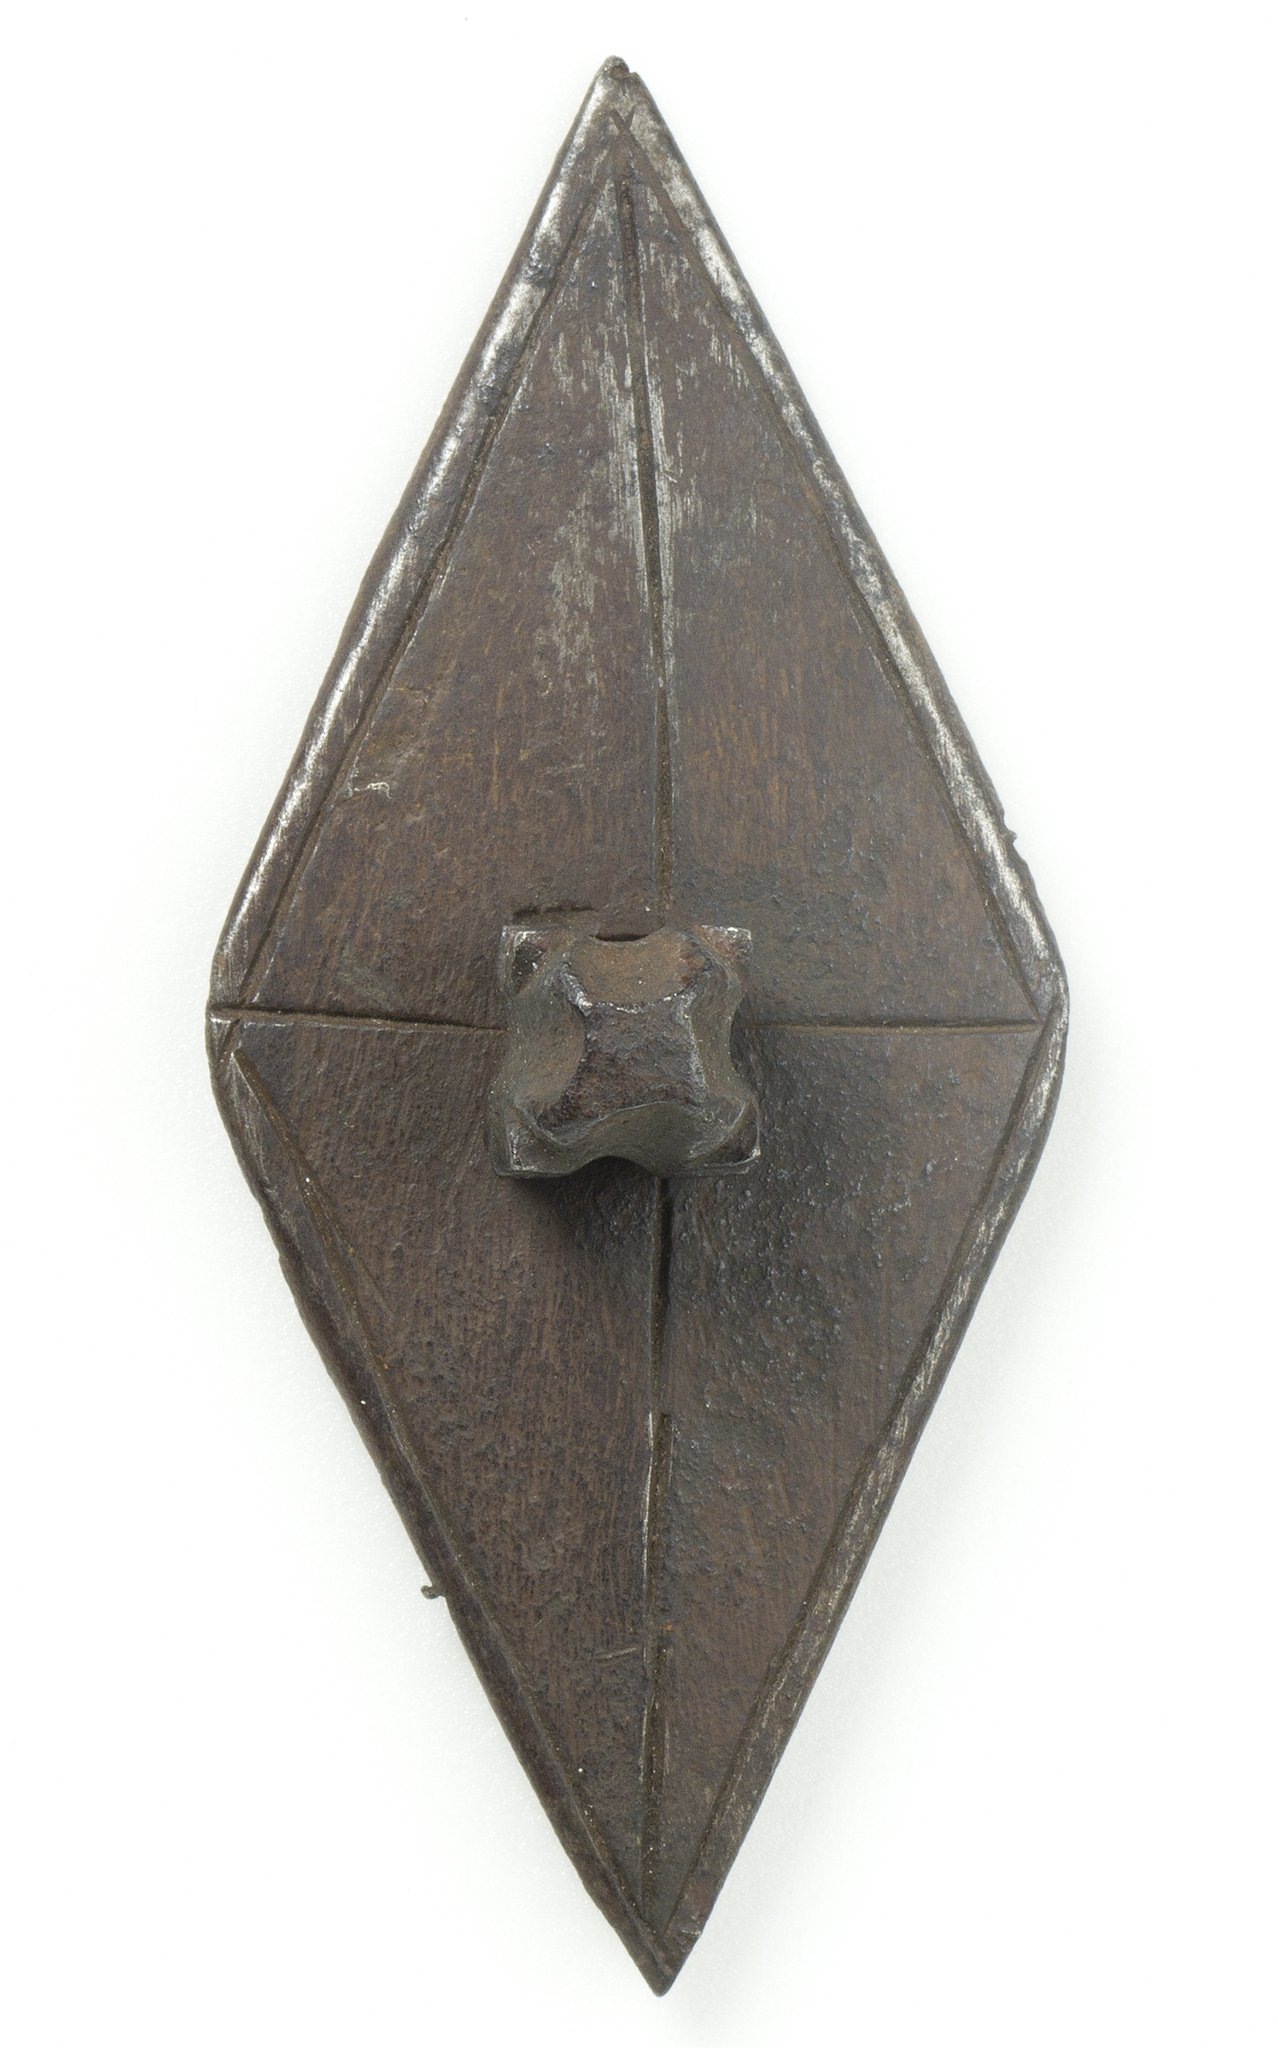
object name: plate and nail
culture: european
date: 1401-1600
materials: iron